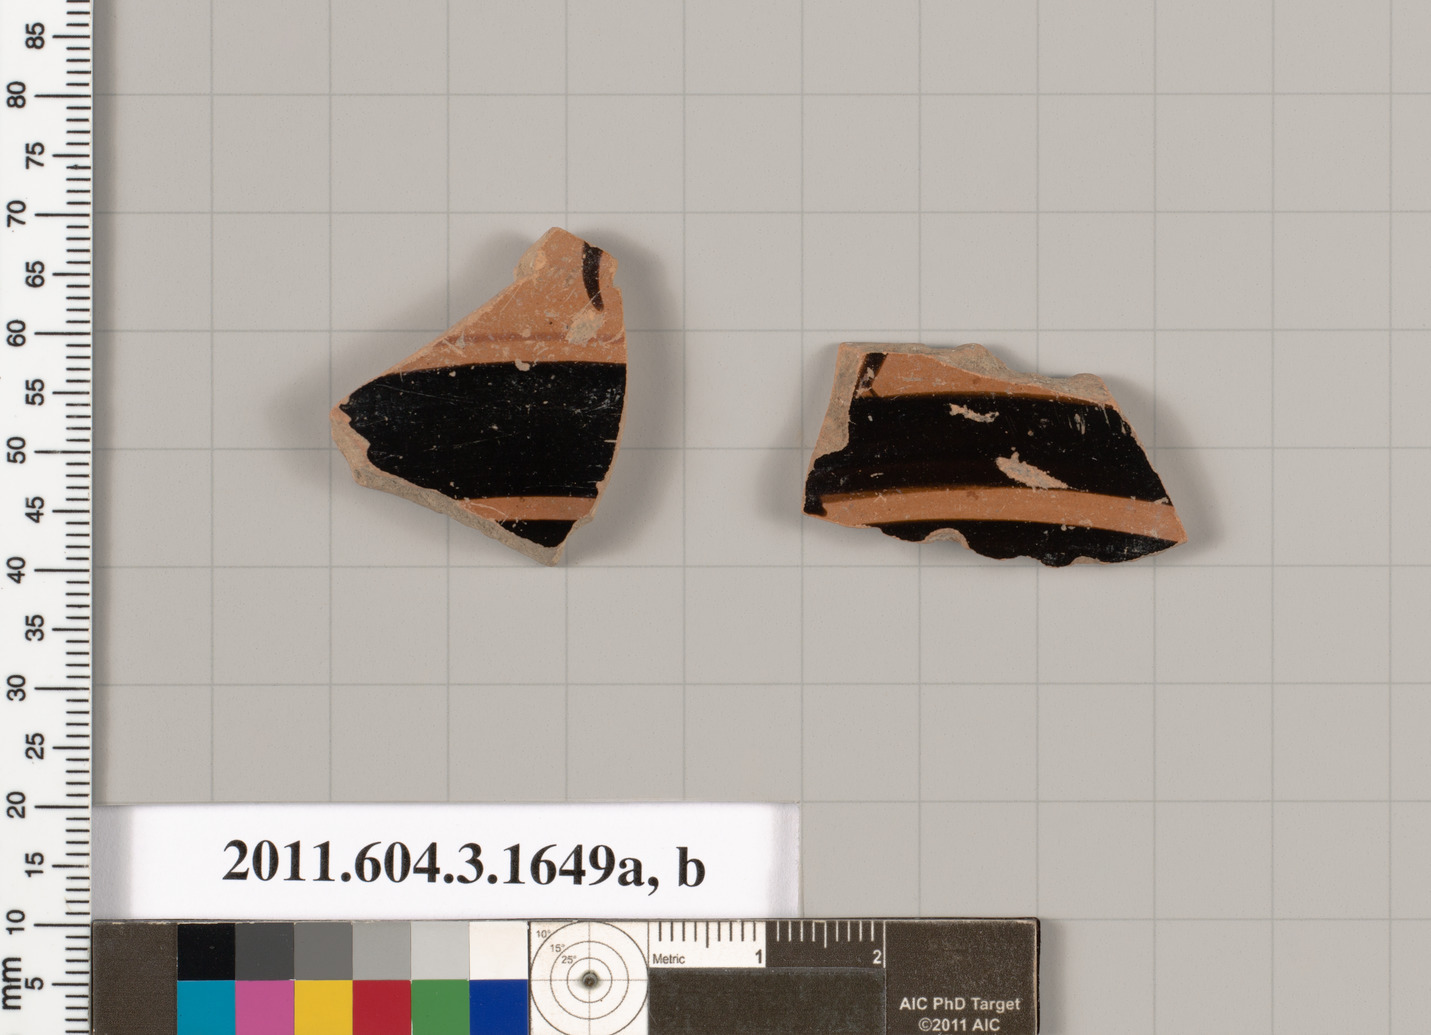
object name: kylix fragment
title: Terracotta fragments of kylikes: Band or lip cups (drinking cups)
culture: greek, attic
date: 550-526 BCE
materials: terracotta